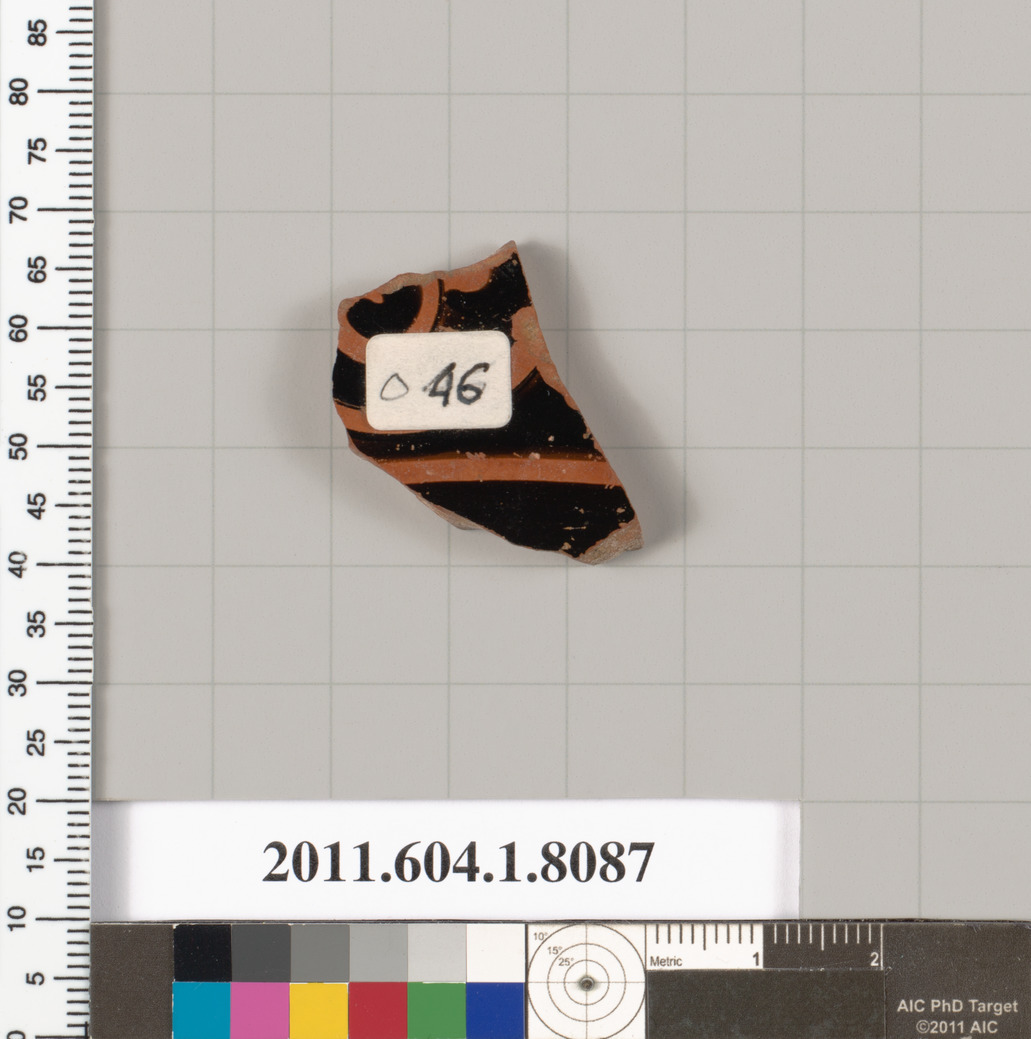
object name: kylix fragment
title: Terracotta fragment of a kylix (drinking cup)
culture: greek, attic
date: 510-500 BCE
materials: terracotta